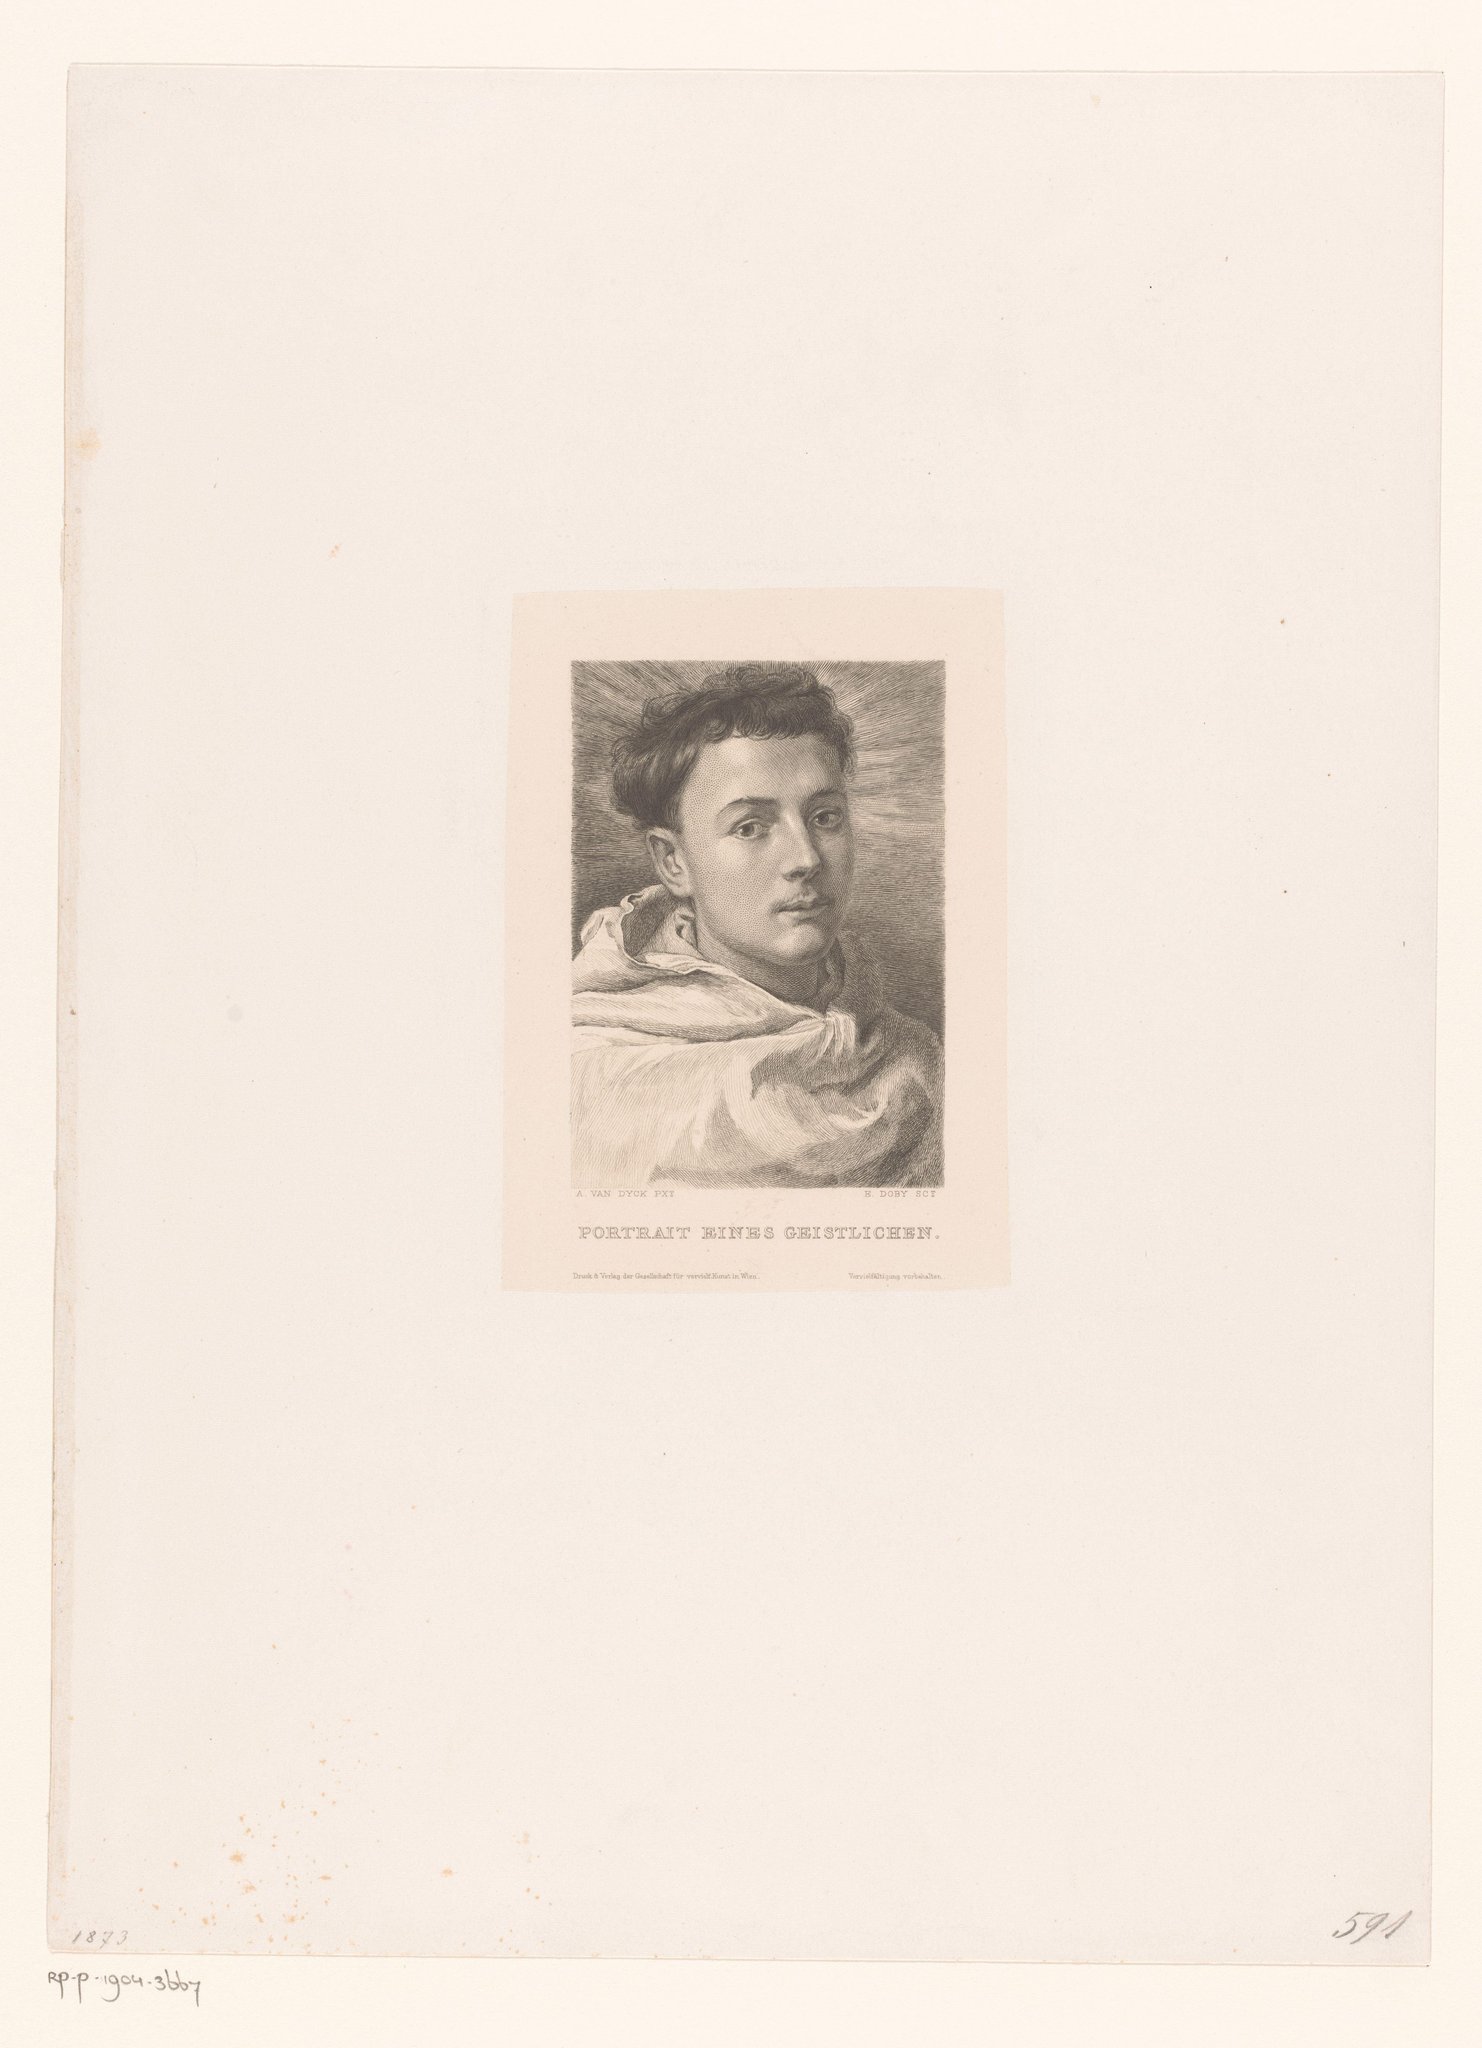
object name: print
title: Portret van een onbekende geestelijke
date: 1844-1904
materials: paper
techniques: etching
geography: vienna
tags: anonymous historical person portrayed alone, monk(s), friar(s)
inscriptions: collector's mark: Lugt 2228